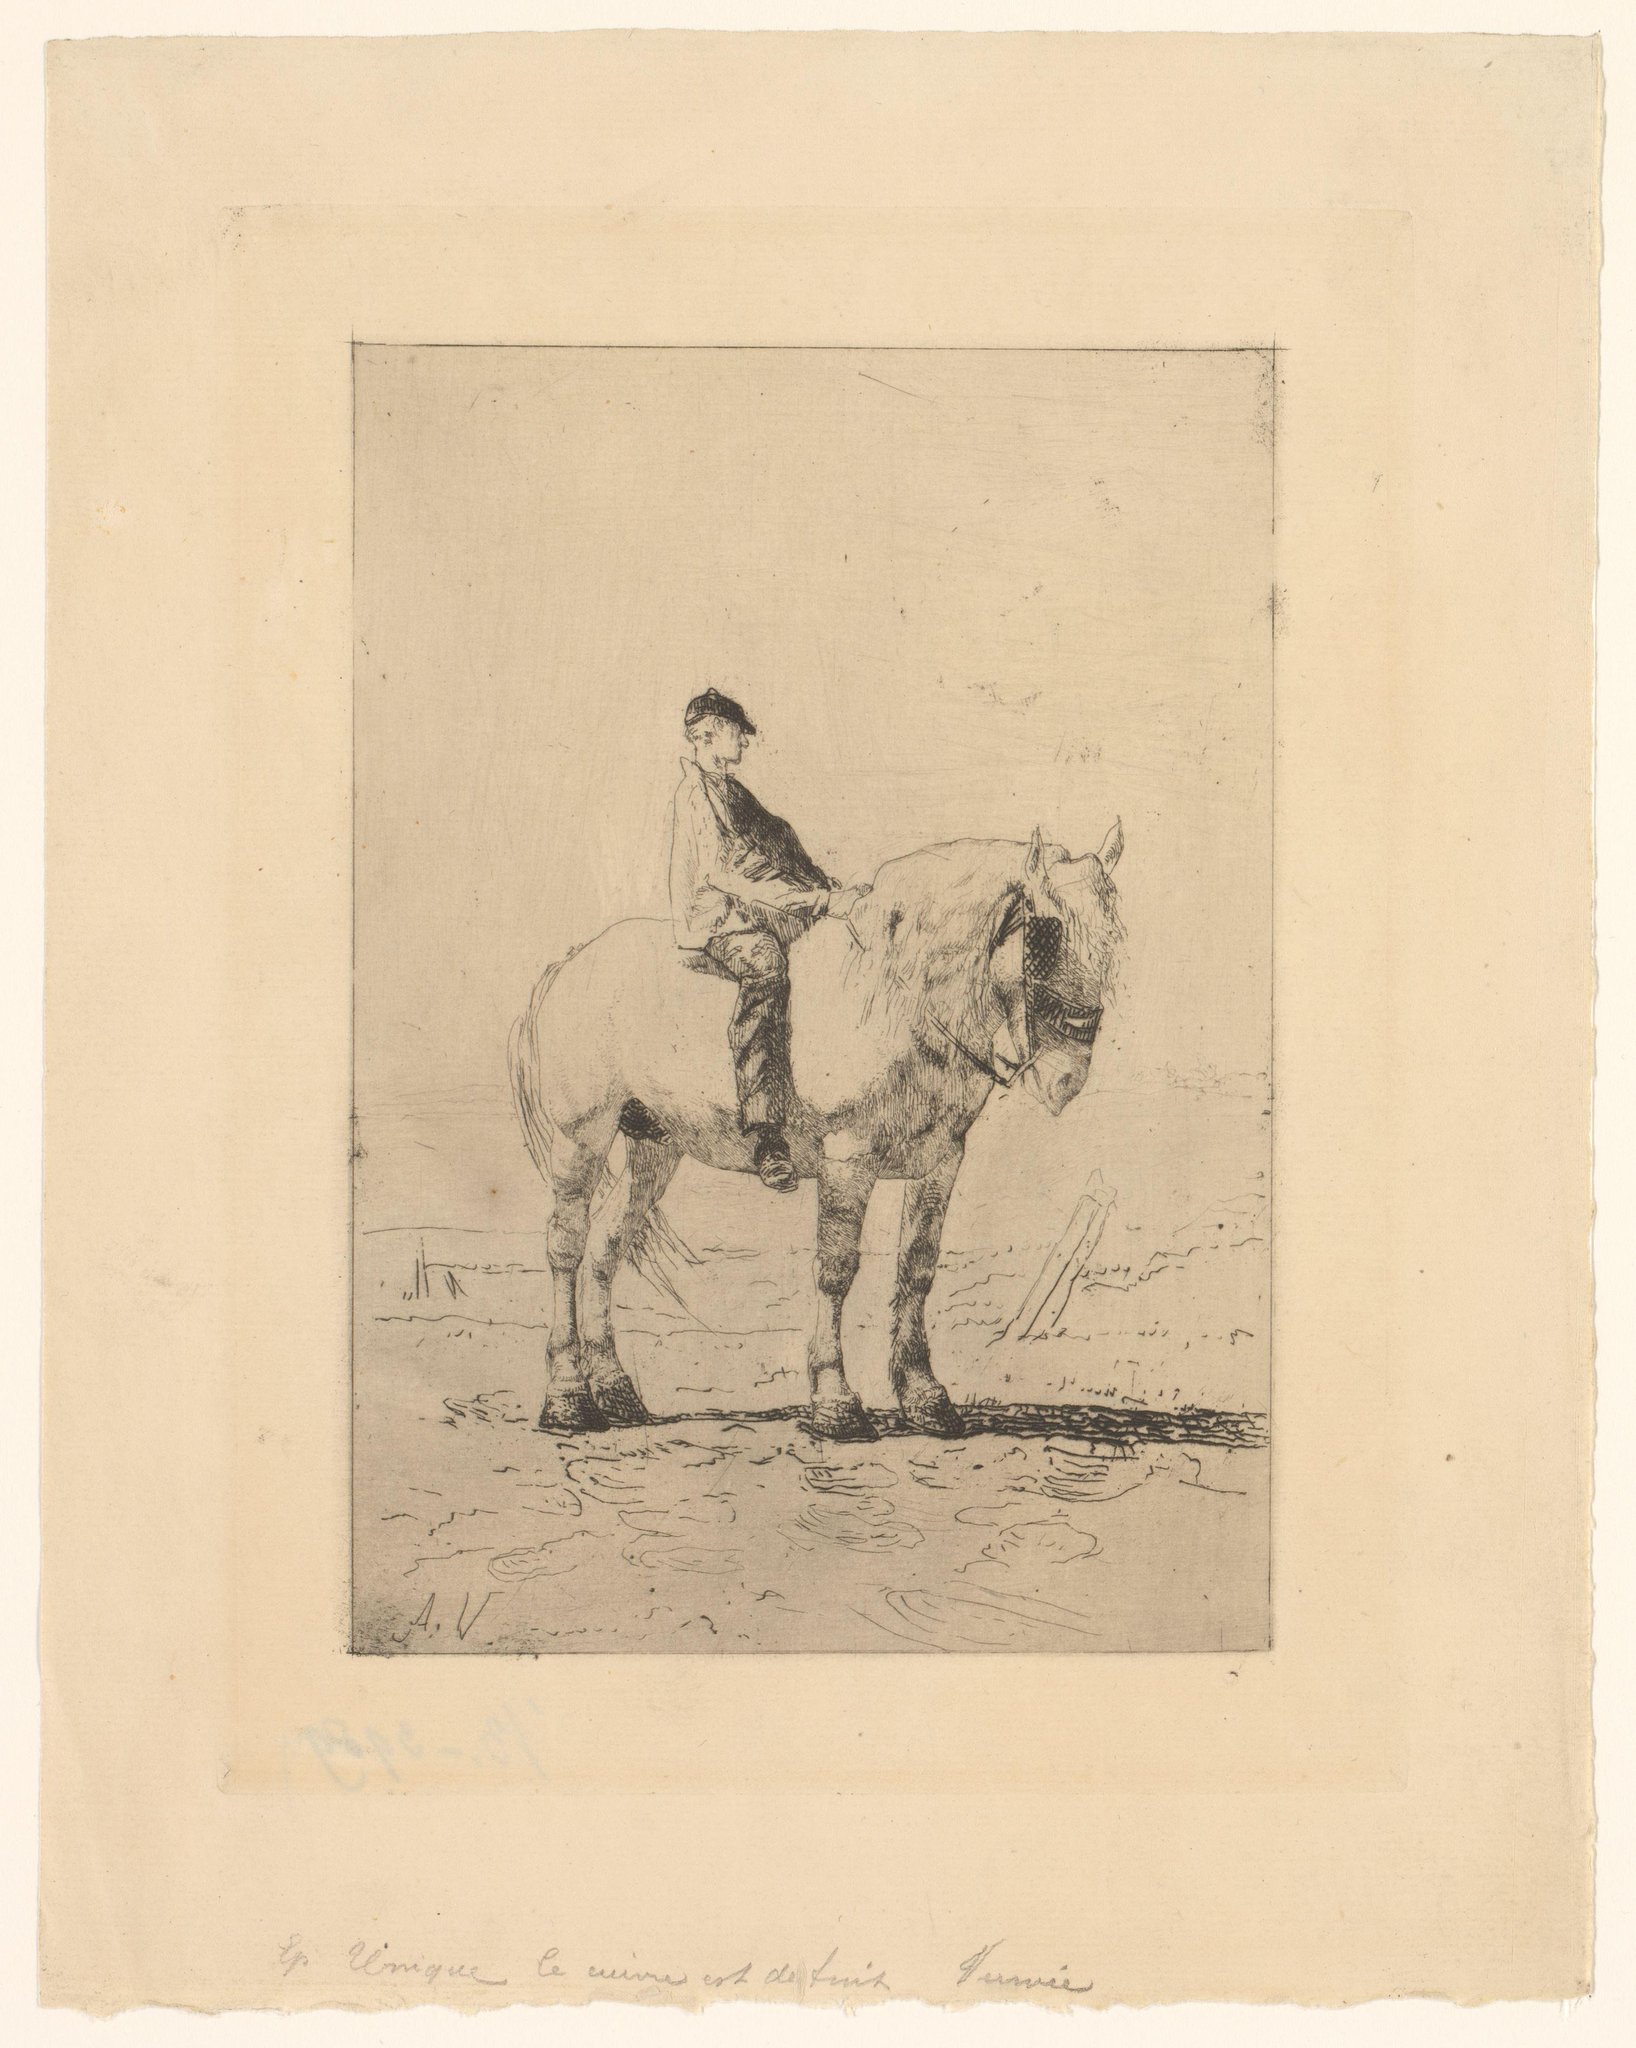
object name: print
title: Jongen te paard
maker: alfred verwee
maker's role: print maker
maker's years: 1838-1895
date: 1848-1895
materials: paper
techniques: etching, intaglio, retroussage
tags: riding a horse, ass, or mule; rider, horseman, jockey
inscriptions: inscription: ‘Ep Unique le cuivre est de tuit Verwée’, collector's mark: Lugt 2228